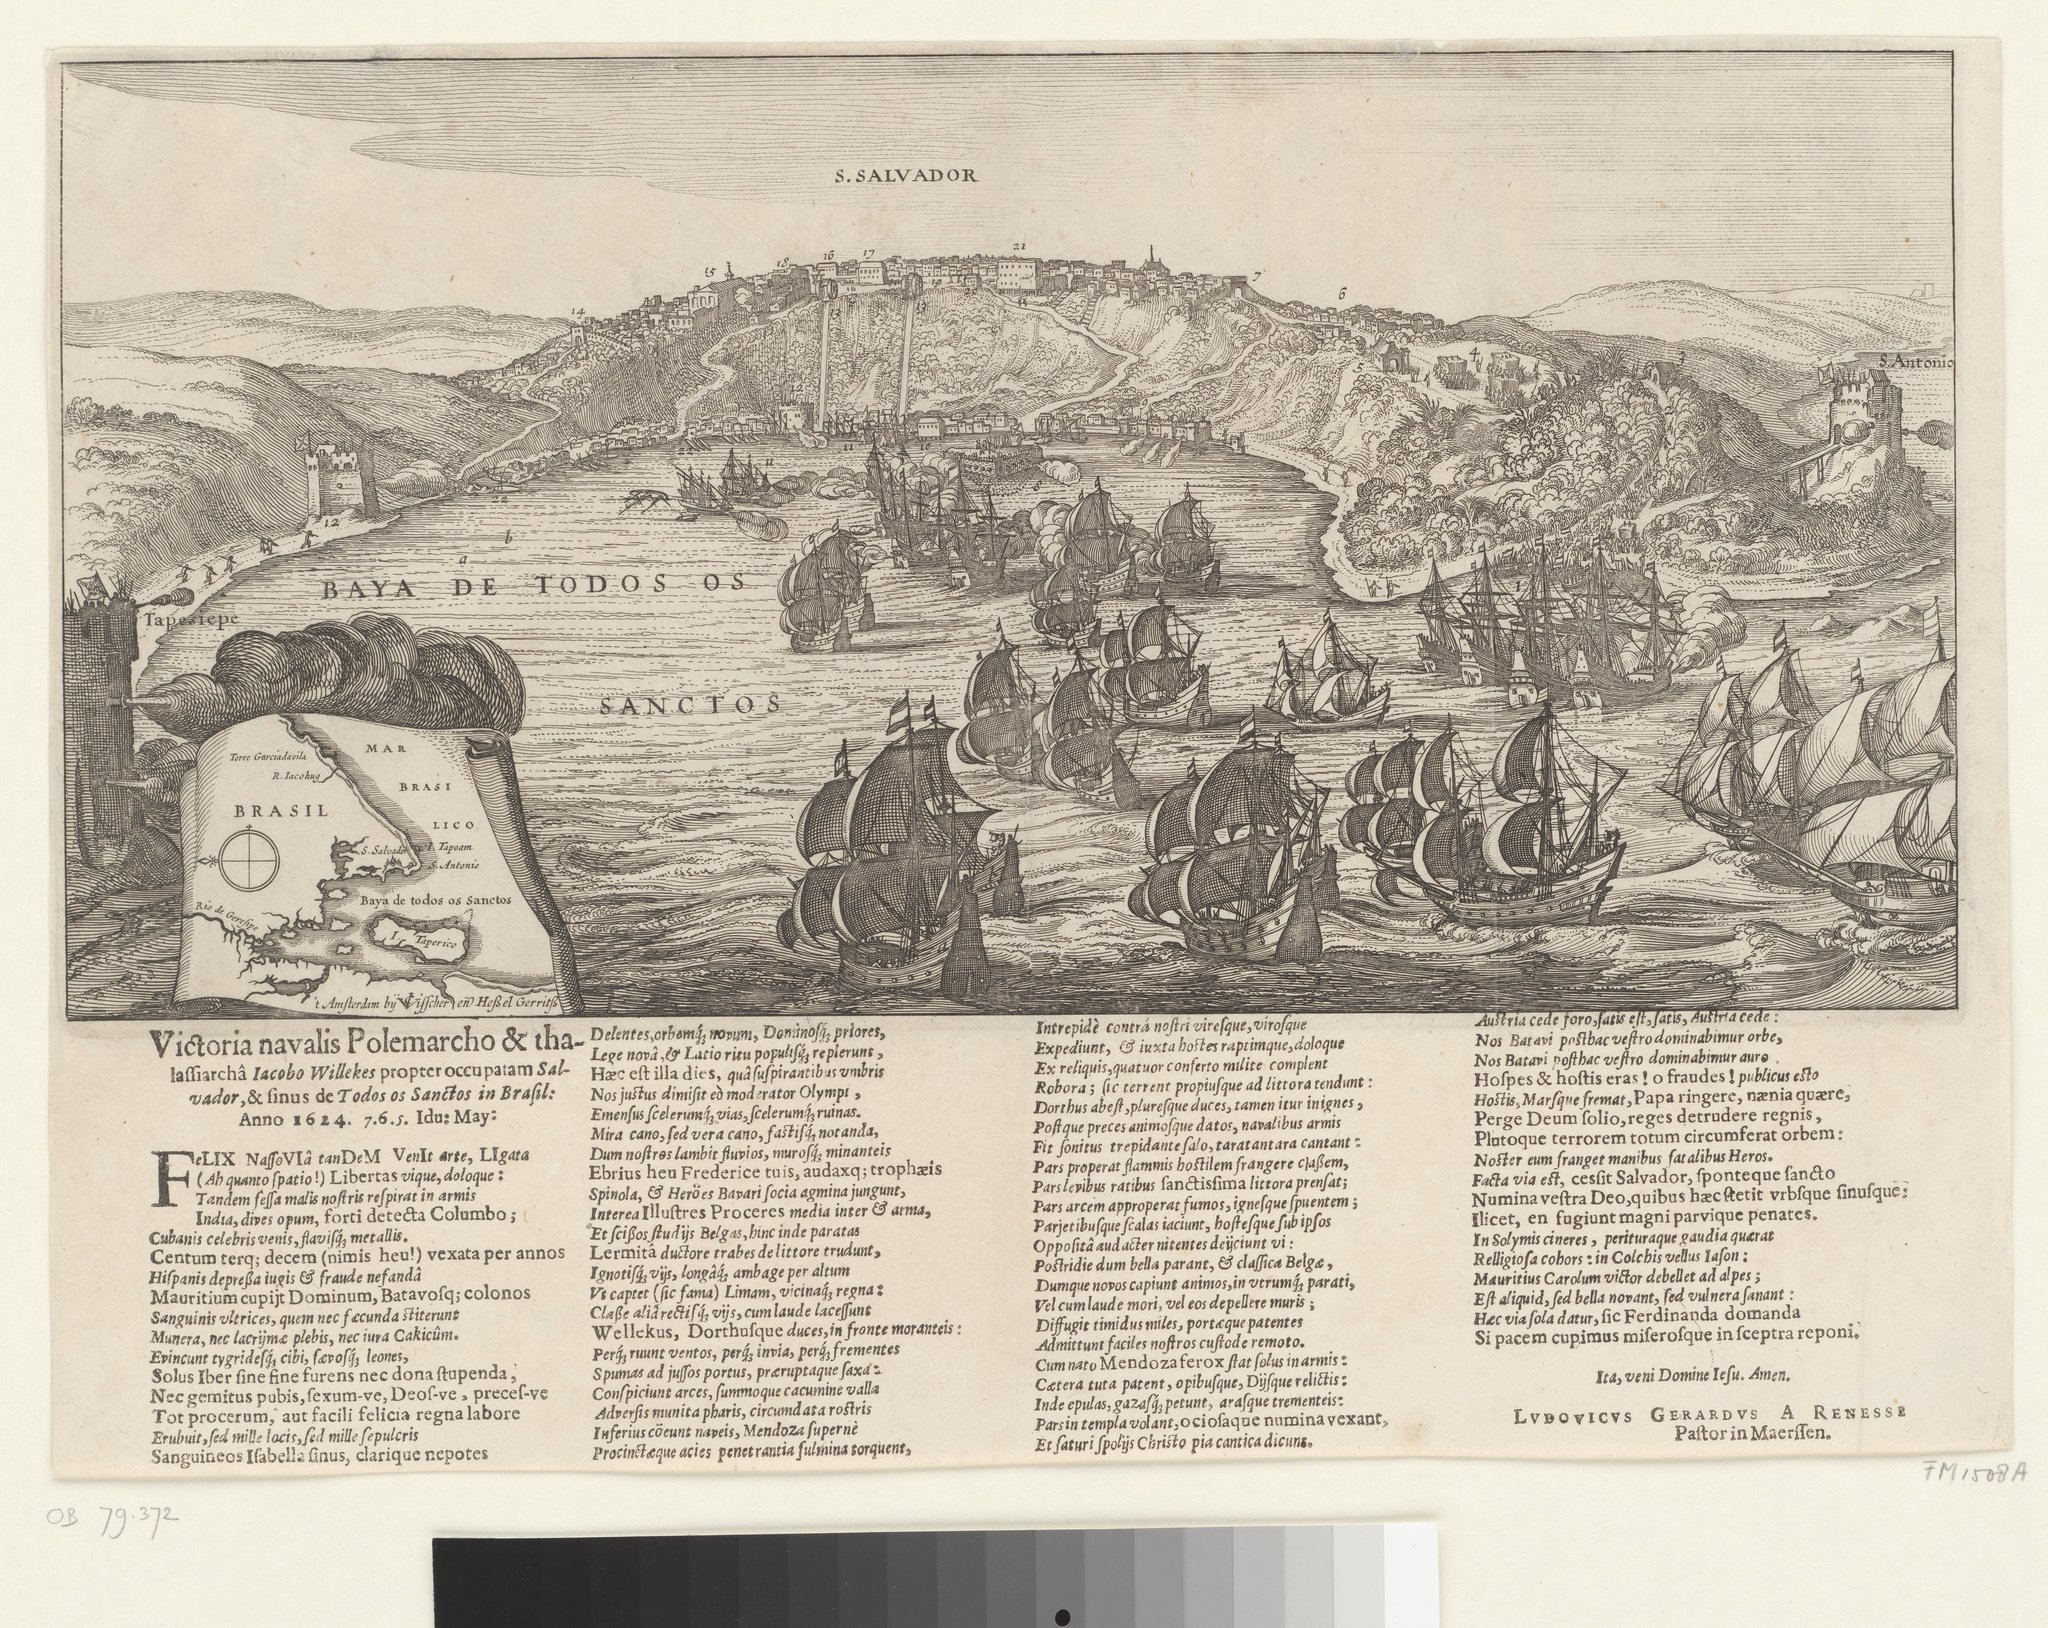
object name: print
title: Verovering van San Salvador in Brazilië door admiraal Jacob Willekes, 1624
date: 1624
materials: paper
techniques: etching, letterpress printing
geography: amsterdam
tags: amsterdam, battle (+ naval force), capture of city (after the siege)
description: De verovering van San Salvador in Brazilië door admiraal Jacob Willekes voor de WIC, 10 mei 1624. Gezicht op de stad en forten aan de ingang van de baai van waaruit de Hollandse vloot beschoten wordt. Linksonder een inzet met een kaartje van het groter gebied. Onder de plaat gedrukt een tekst in 4 kolommen in het Latijn.